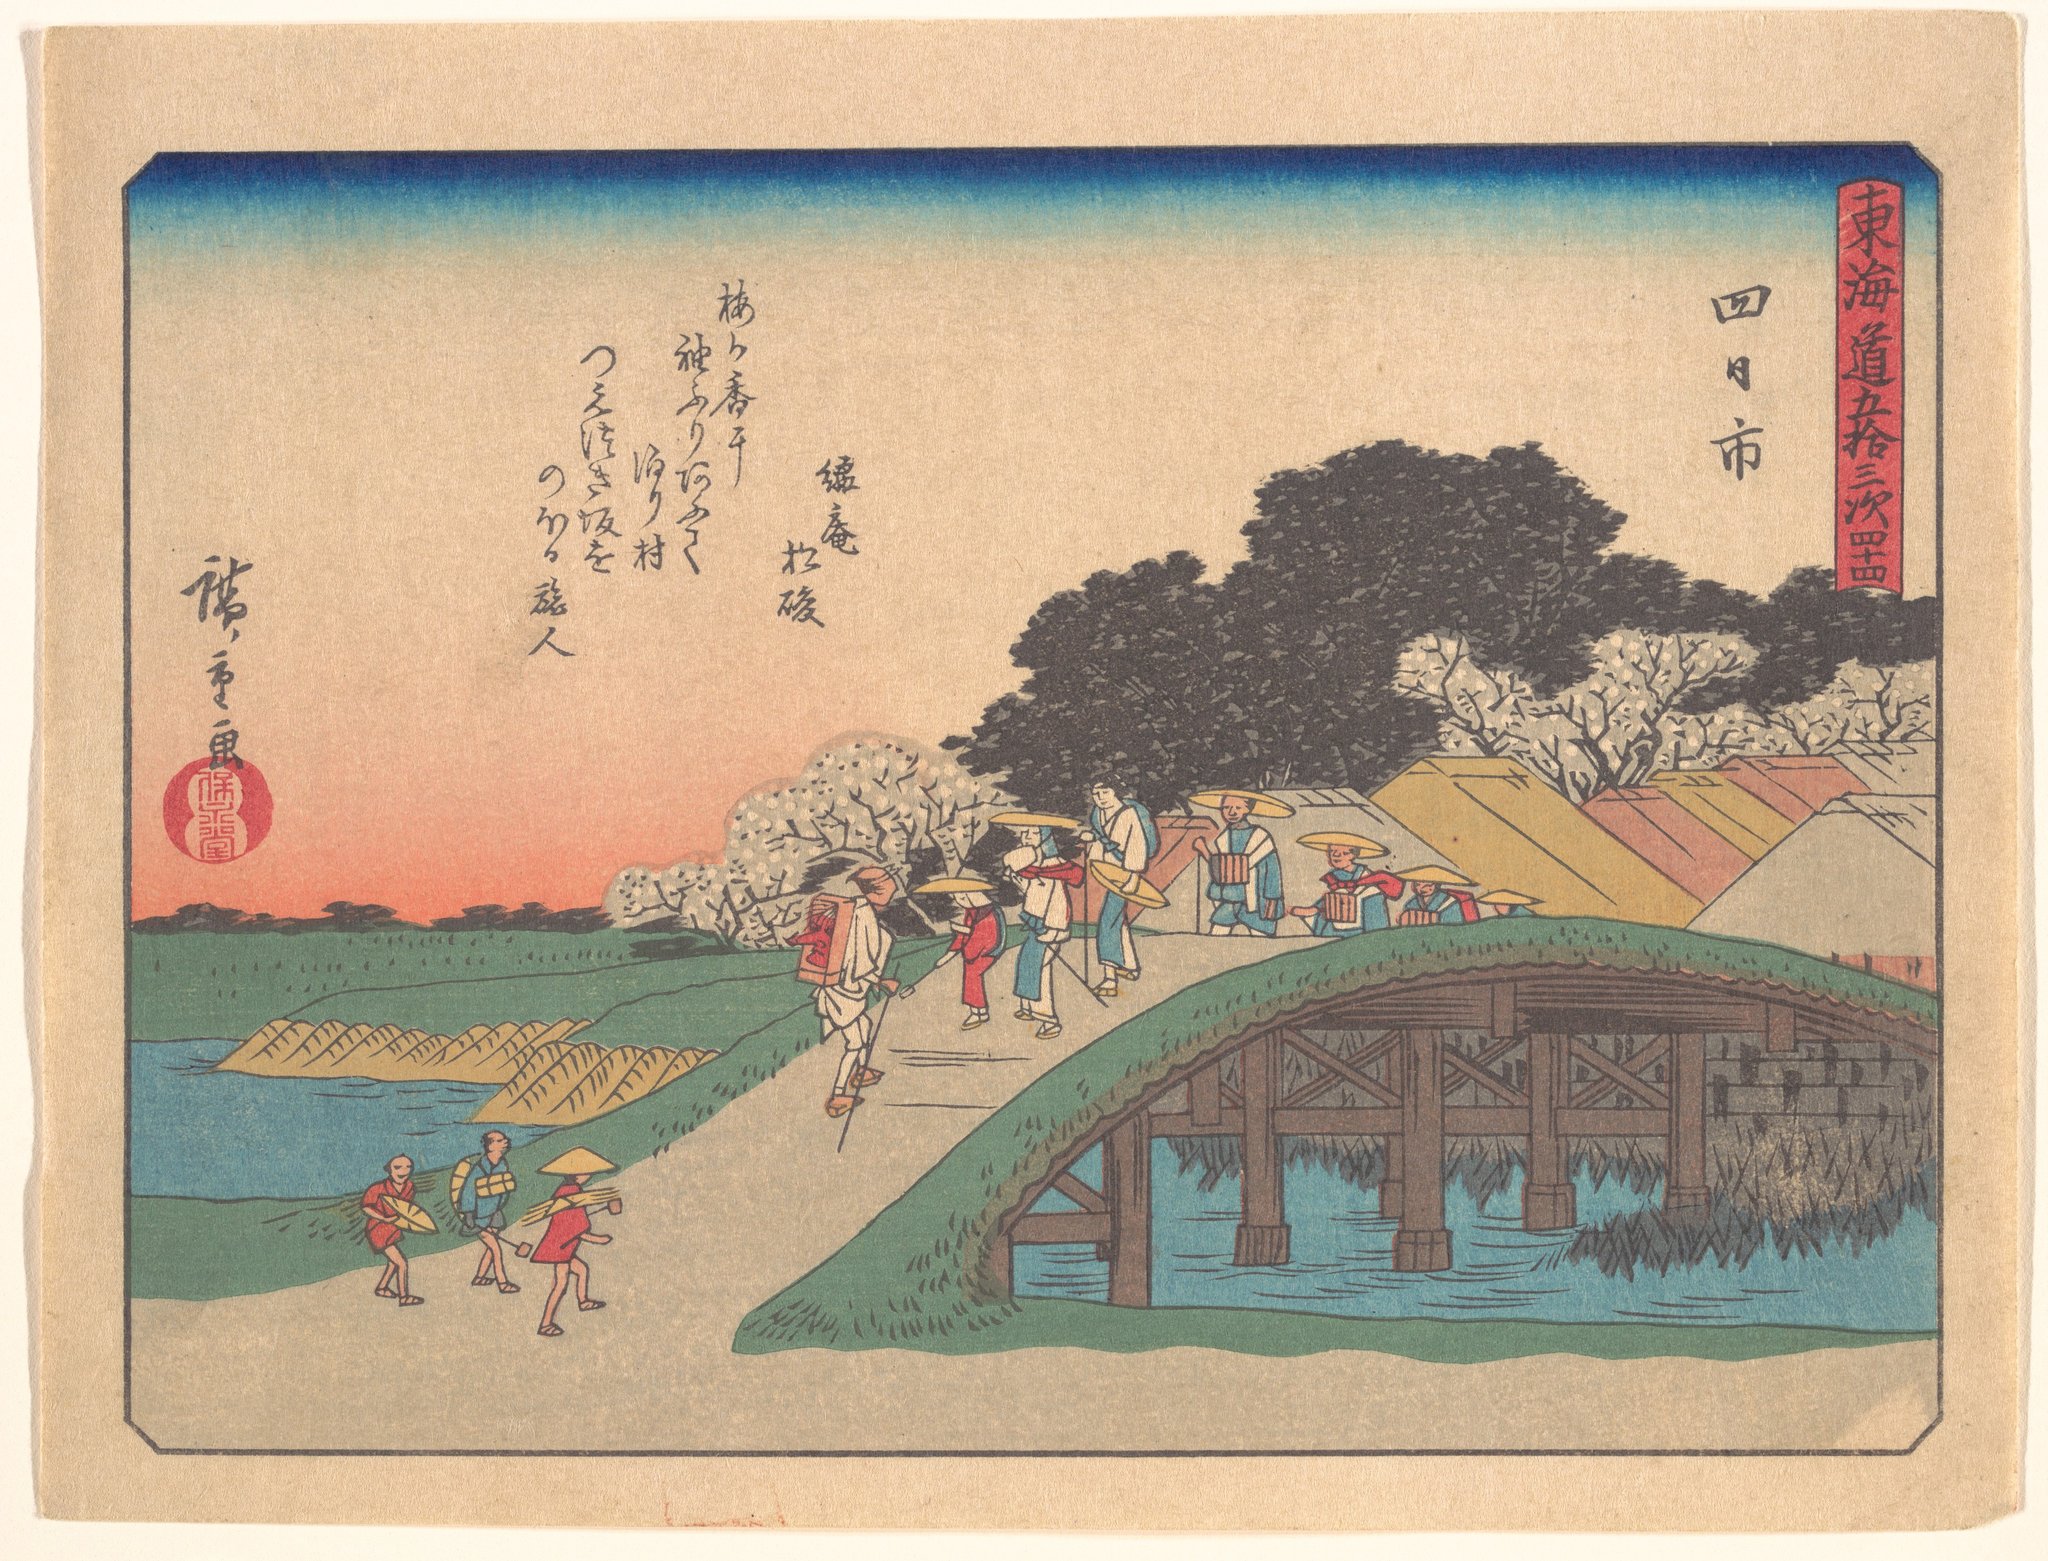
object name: print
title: Yokkaichi, from the series The Fifty-three Stations of the Tōkaidō Road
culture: japanese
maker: utagawa hiroshige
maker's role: artist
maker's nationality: japanese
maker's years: 1797-1858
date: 1901-1933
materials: ink, paper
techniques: woodblock print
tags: human figures,bridges,trees